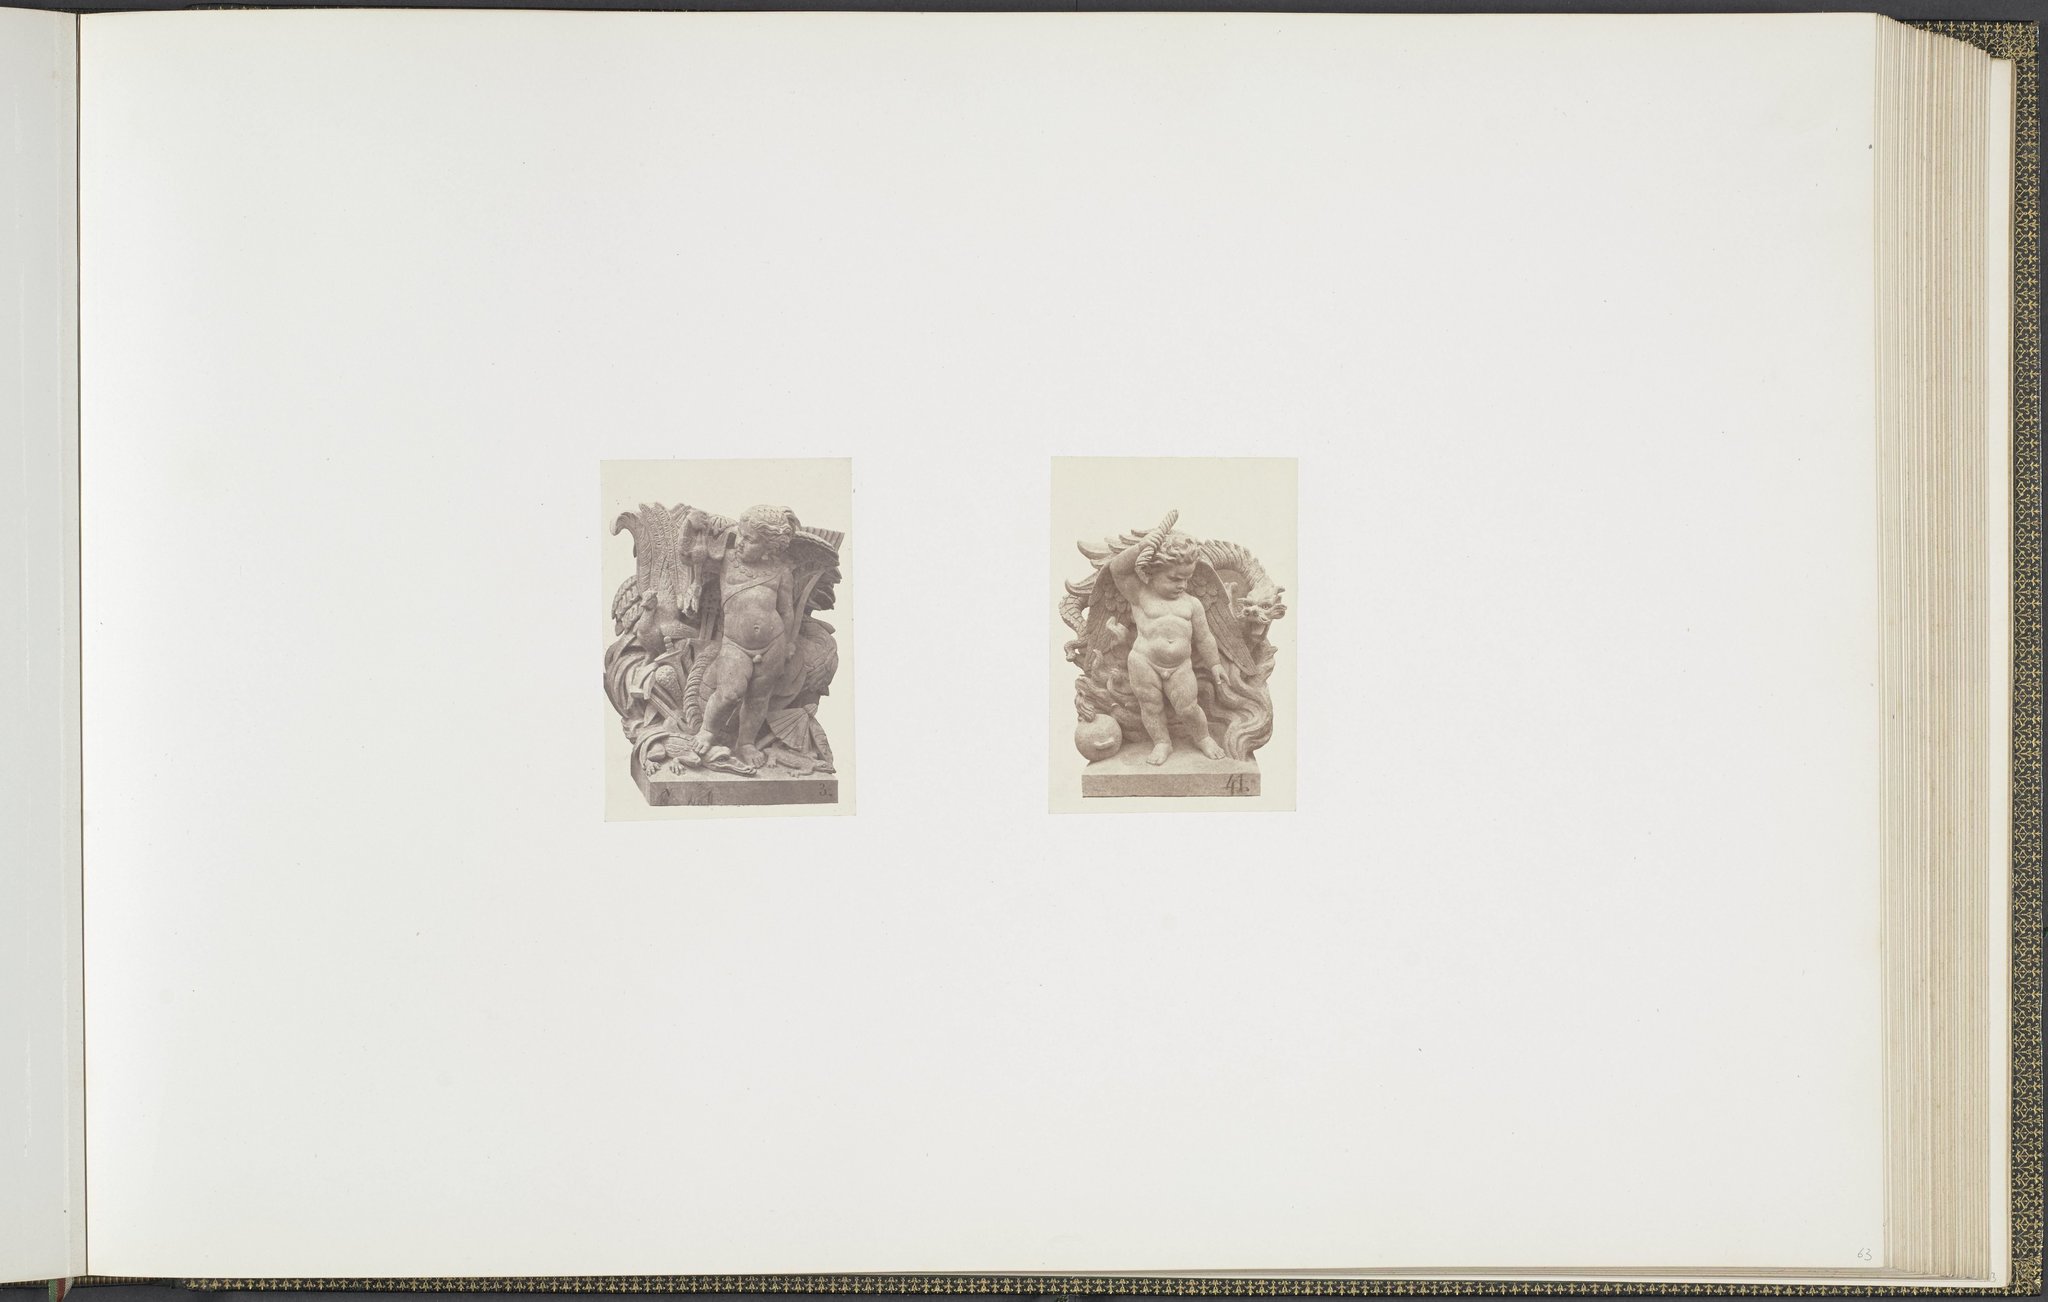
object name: album leaf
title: Gipsmodellen voor beeldhouwwerken op het Palais du Louvre: links "L'Océanie" door De Herleg en rechts "Le Feu" door Henri-Frédéric Iselin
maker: édouard denis baldus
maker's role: fotograaf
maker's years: 1813-1889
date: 1855-1857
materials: paper, photographic support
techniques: salted paper print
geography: paris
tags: piece of sculpture, reproduction of a piece of sculpture, permanent exhibition, museum, paris, tuileries palace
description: Onderdeel van Réunion des Tuileries au Louvre 1852-1857, album 1.